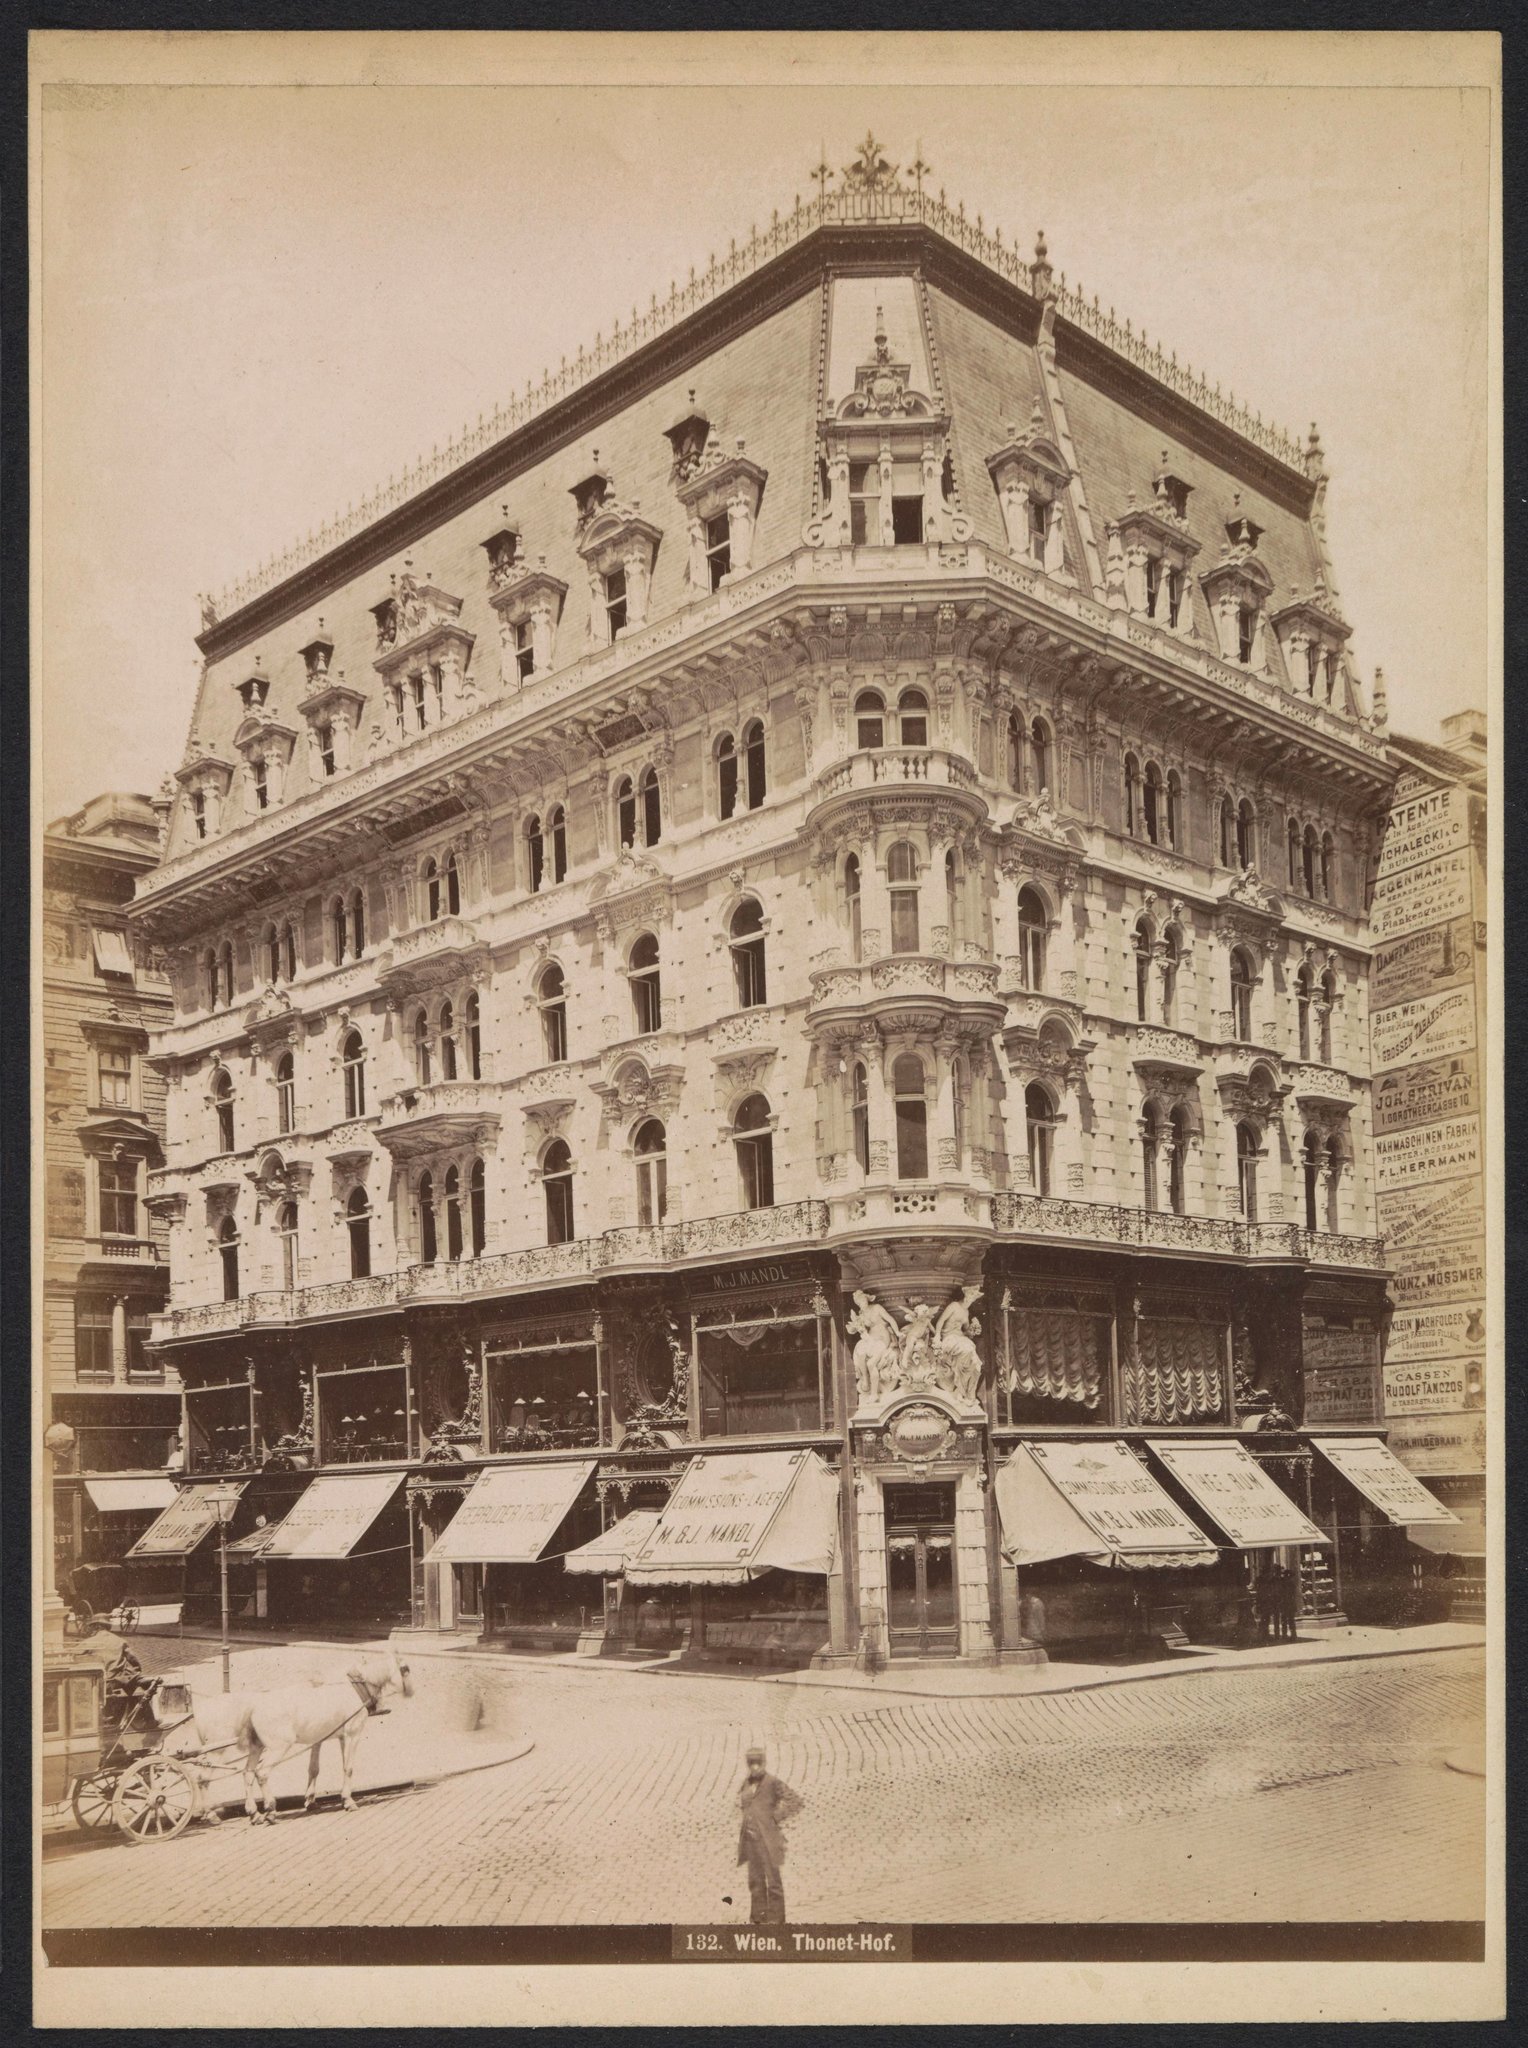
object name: photograph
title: Gezicht op de Thonethof in Wenen, Oostenrijk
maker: Anonymous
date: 1851-1900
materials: cardboard, paper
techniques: albumen print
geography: vienna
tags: exterior ~ representation of a building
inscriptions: number: ‘132.’